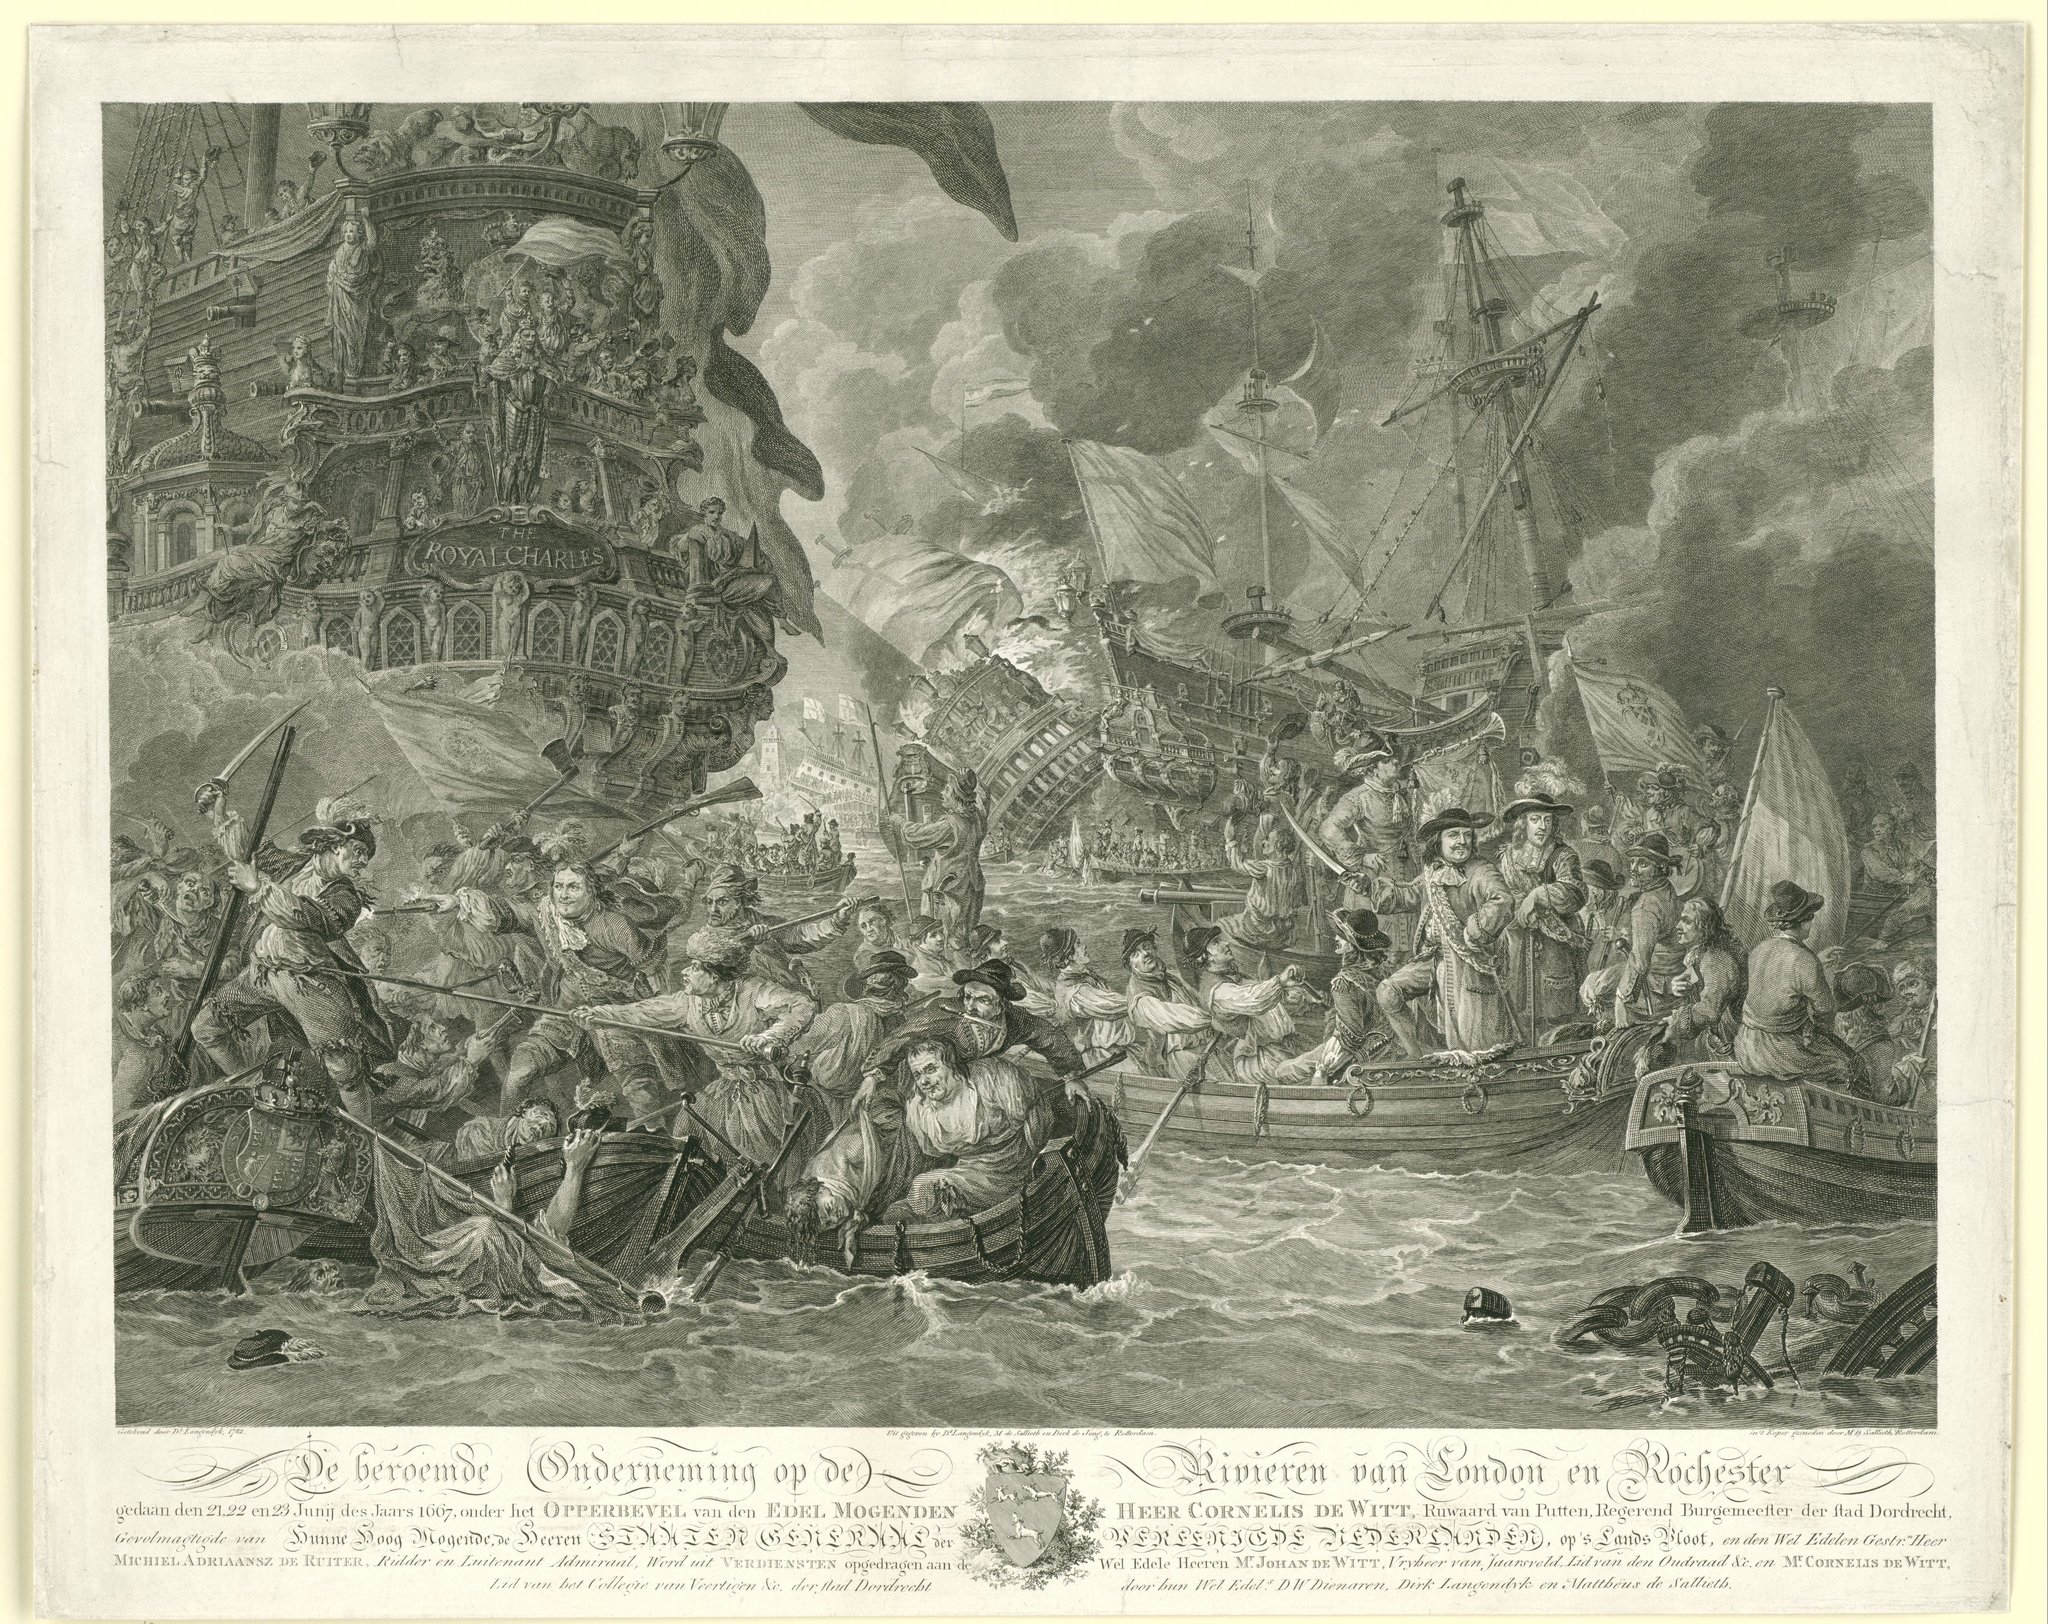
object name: print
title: The Dutch Raid on the Medway and the Capture of the Royal Charles, 1667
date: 1782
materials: paper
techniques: engraving, etching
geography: rotterdam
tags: flushing, michiel adriaenszoon de ruyter, dordrecht, the hague, cornelis de witt, battle (+ naval force), raid on the medway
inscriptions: inscription: ‘D Langendijk / Md Sallieth / JK de Jong’, caption: ‘De beroemde Onderneming op de Rivieren van London en Rochester...’, address: ‘Uit gegeven bij Dk Langendyk, M.D. Sallieth en Dirk de Jong te Rotterdam’, signature: ‘in t Koper gesneden door M.D. Sallieth, Rotterdam’, signature: ‘Getekend door Dk Langendyk, 1782’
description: Man-tot-man-gevechten in sloepen, op de achtergrond de vernietiging van de Engelse vloot bij Chatham, links de verovering van het Engelse vlaggeschip de Royal Charles op 22 juni 1667. Centraal in een sloep staan Cornelis de Witt en Michiel Adriaenszoon de Ruyter, links kapitein Jan van Brakel schietend met zijn pistool. Op de voorgrond de doorgevaren ketting. Episode uit de Tocht naar Chatham op 20-23 juni 1667 door de Staatse vloot onder De Ruyter. Bij de prent behoort een klein blad met de koppen en namen van de hoofdpersonen.